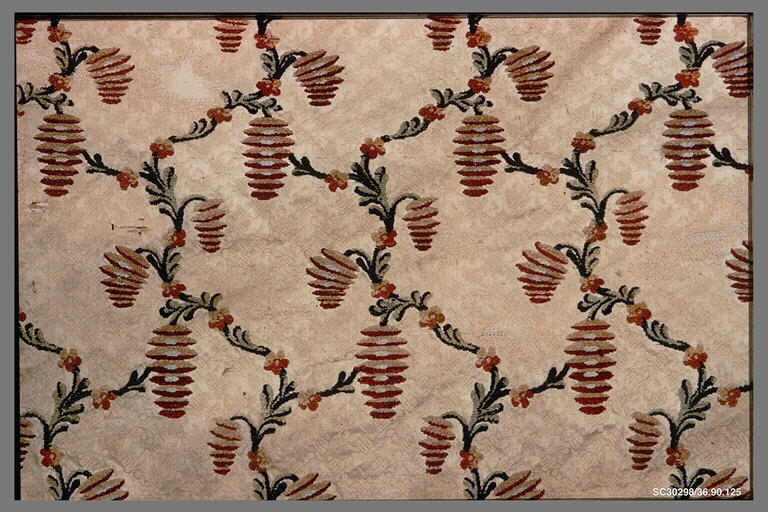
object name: piece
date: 1750-1760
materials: silk